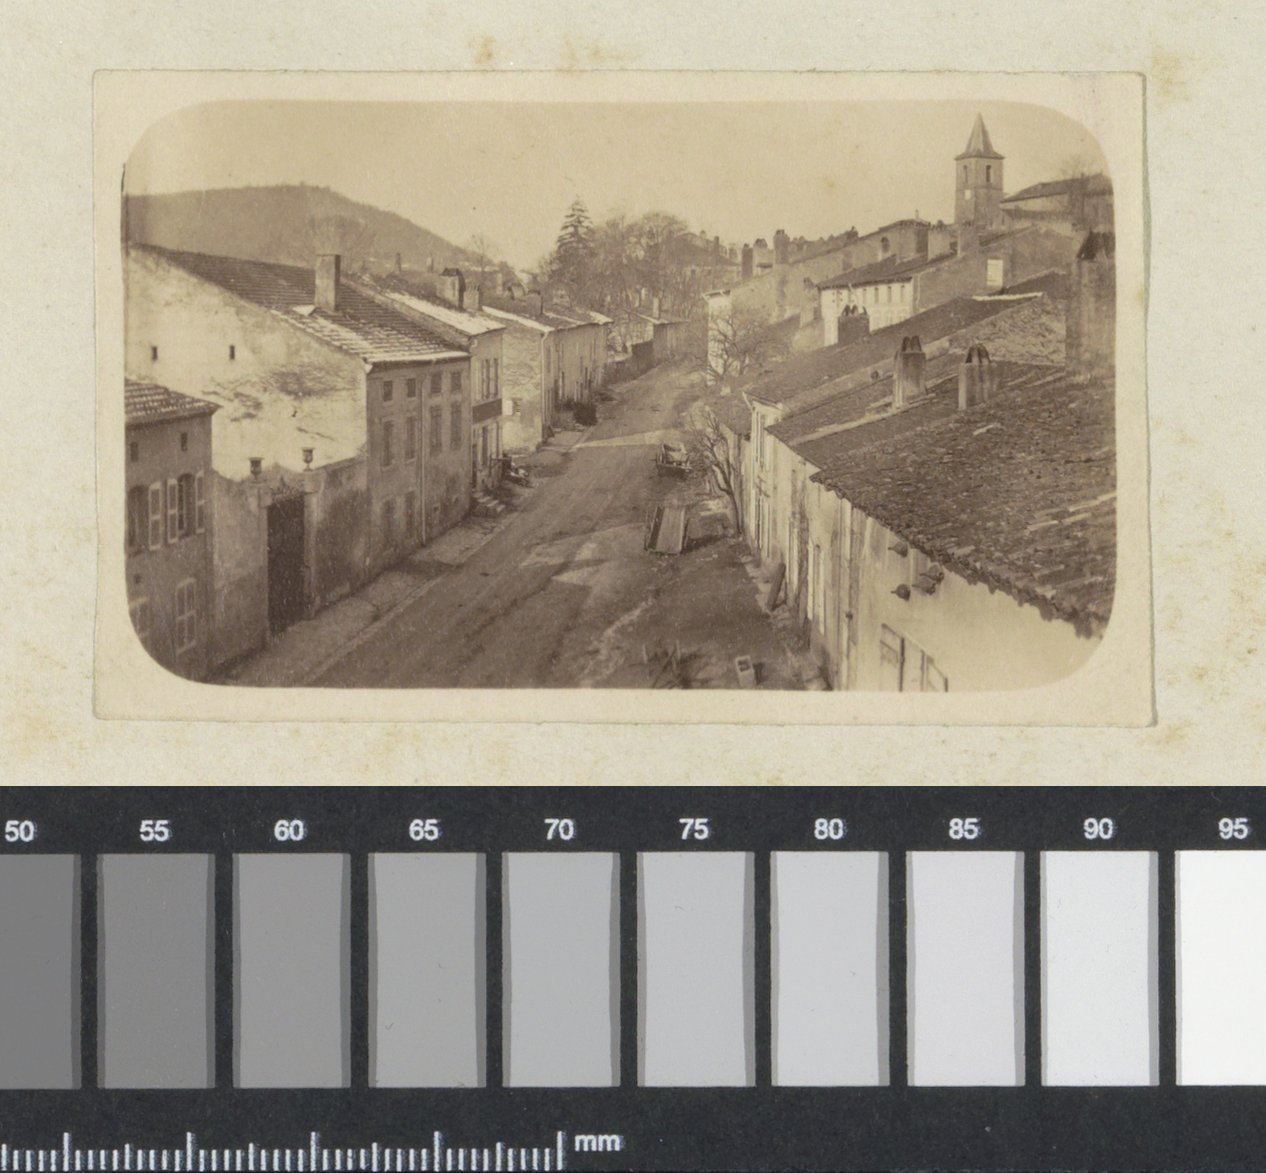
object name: photograph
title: Gezicht op een dorpsstraat, vermoedelijk in Arnaville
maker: Anonymous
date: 1883-1886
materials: photographic support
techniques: albumen print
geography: arnaville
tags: village street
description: Onderdeel van Album van een Franse amateurfotograaf met opnames van familie, militairen, industrie, landschappen en bezienswaardigheden in Frankrijk.